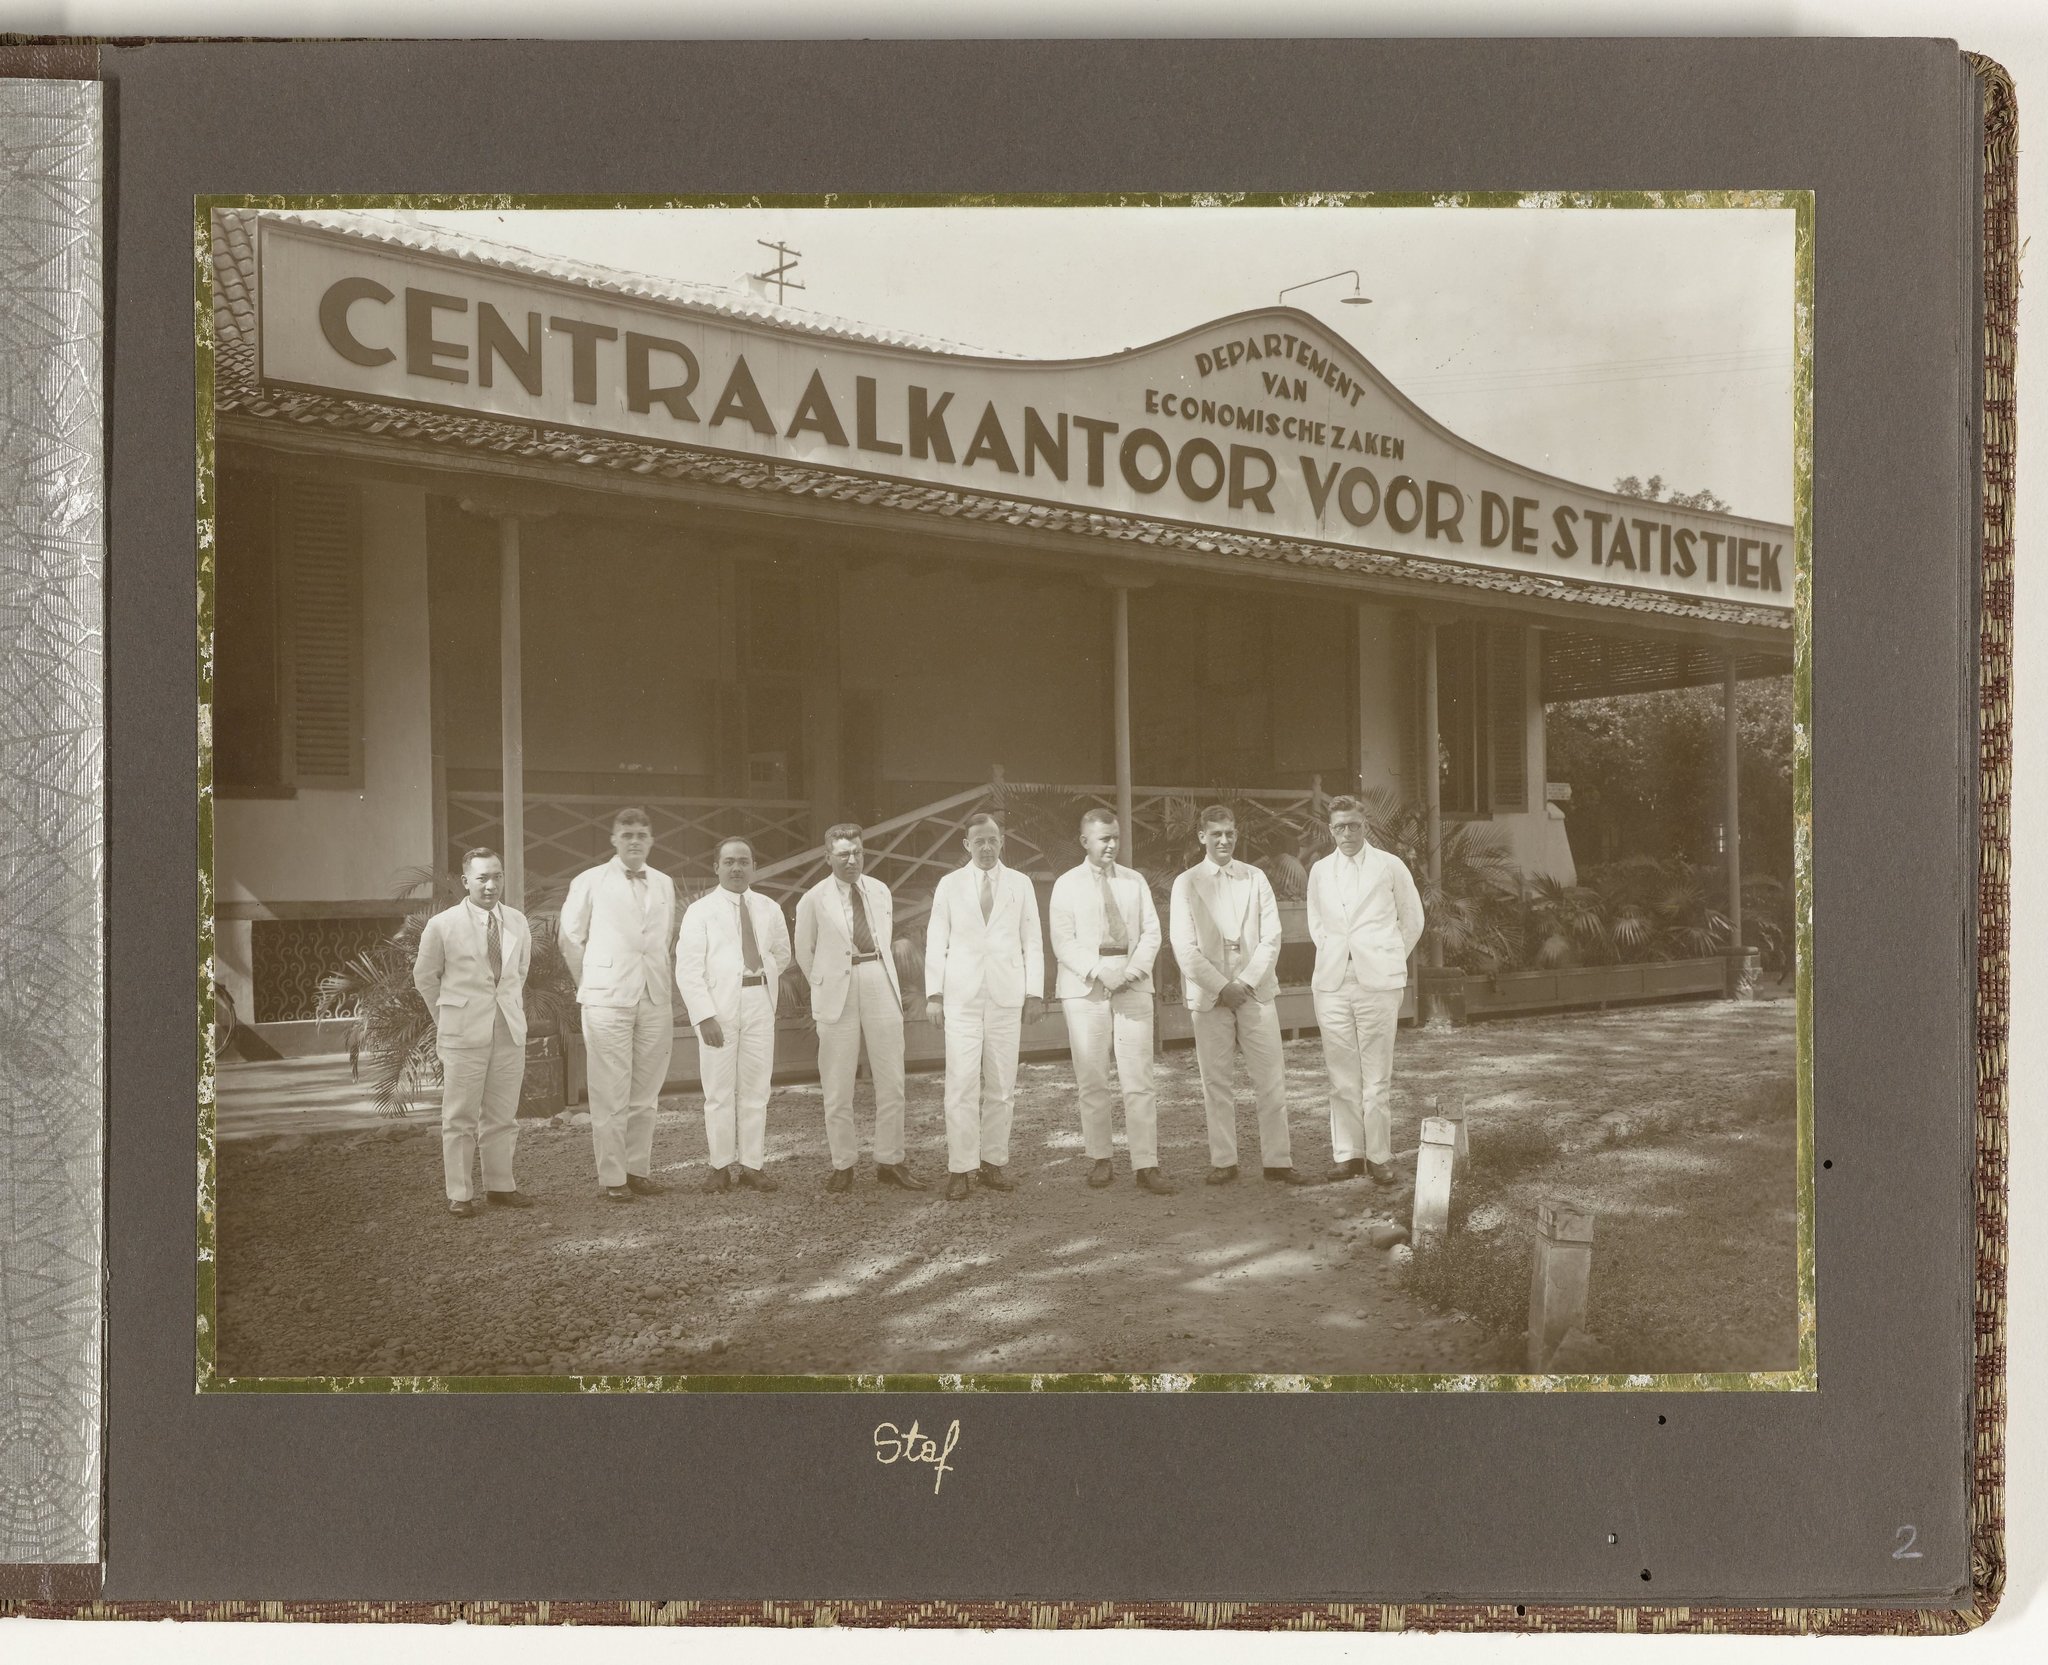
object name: photograph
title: Staf van het Centraal Kantoor voor de Statistiek te Batavia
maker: Anonymous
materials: photographic support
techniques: gelatin silver print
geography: batavia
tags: amsterdam, leiden, colonial system, algebra and statistics, historical persons, batavia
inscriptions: inscription: ‘Staf’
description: In 1920 werd door de Directeur van Landbouw, Nijverheid en Handel een begin gemaakt met bundeling van statischtische werkzaamheden in één Statistisch Kantoor. In 1924 werd dit kantoor samengevoegd met statistiek van in- en uitvoer in het 'Centraal kantoor voor de Statistiek', gevestigd in Weltevreden, met prof. dr. J. van Gelderen als eerste directeur.